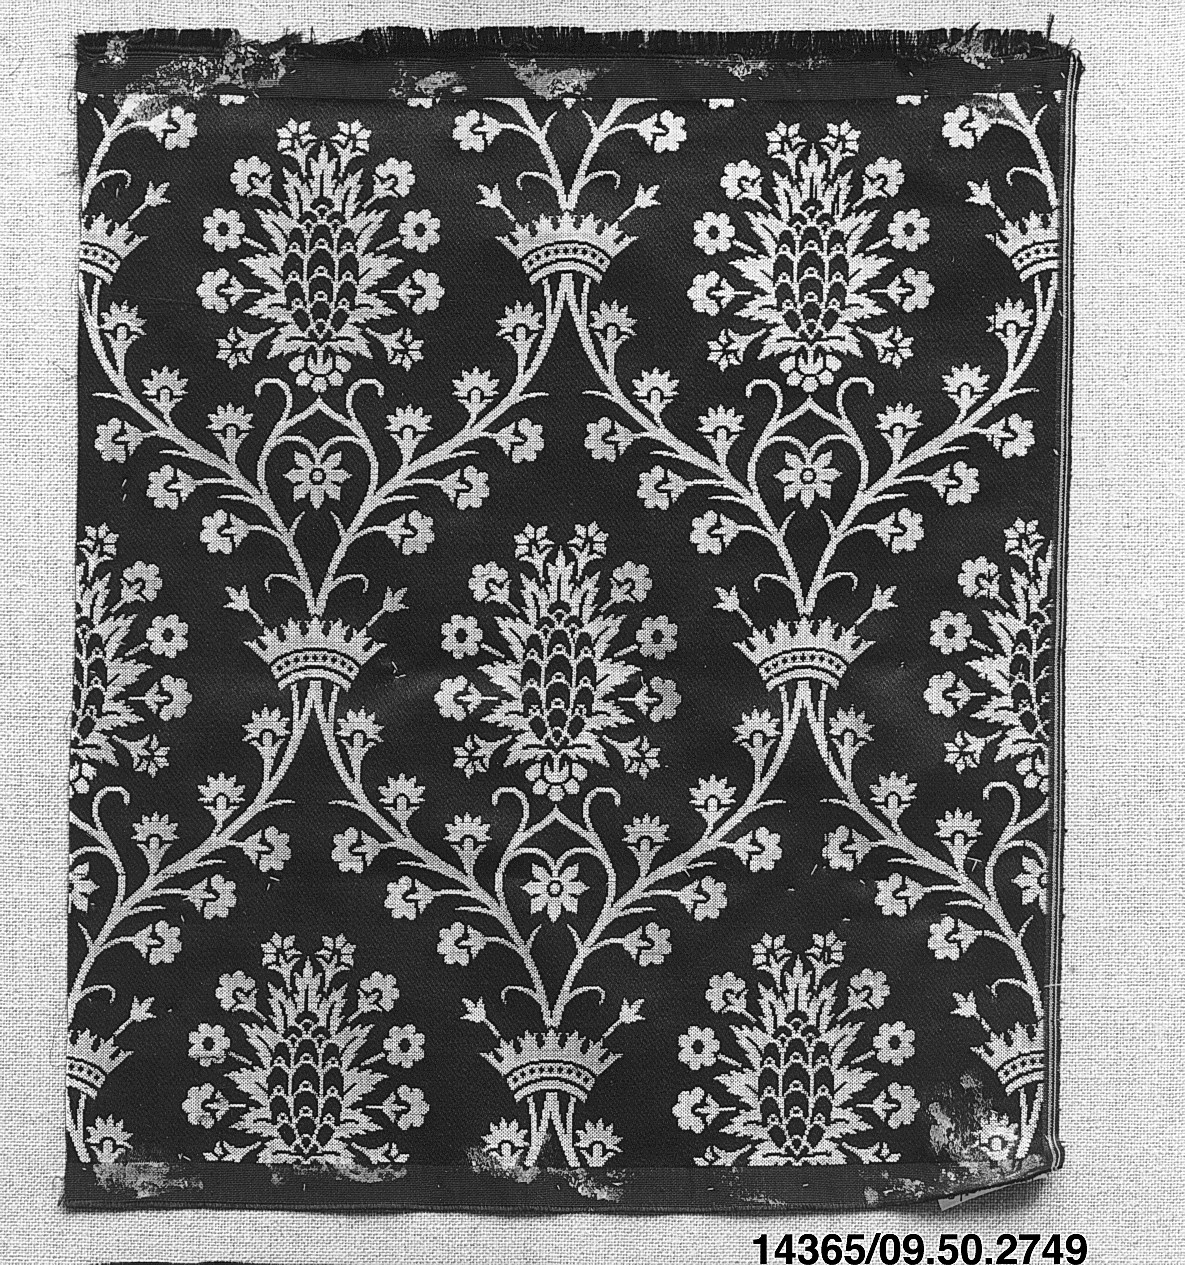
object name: piece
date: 1801-1900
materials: silk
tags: flowers,leaves